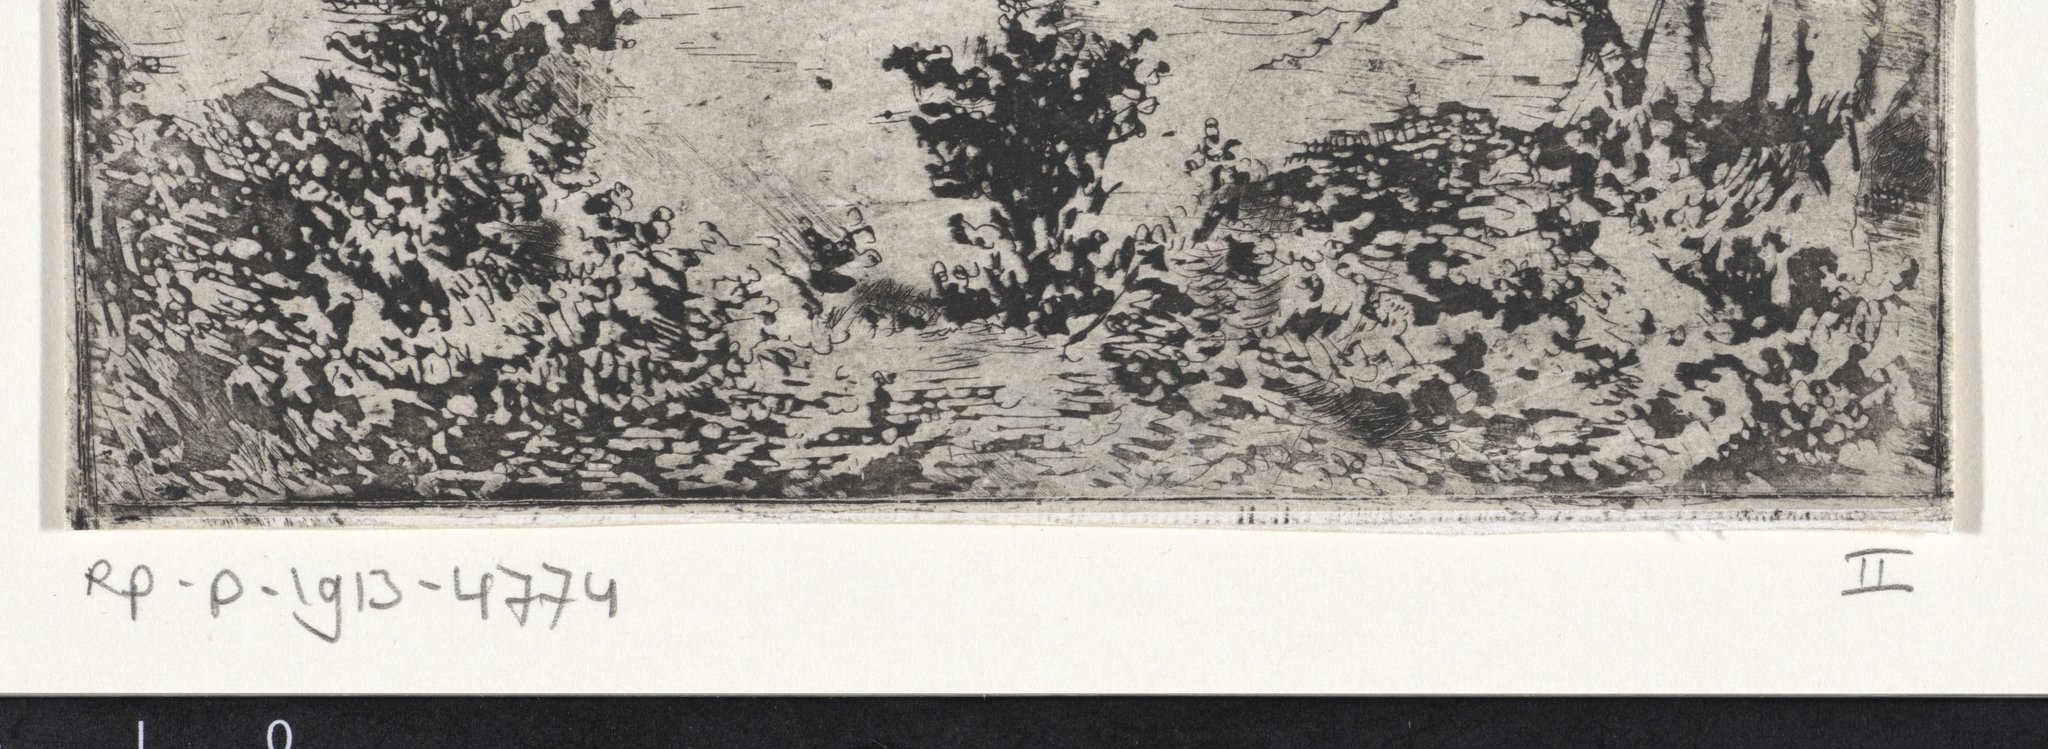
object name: print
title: Landschap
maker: arnoud schaepkens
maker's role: print maker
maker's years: 1816-1904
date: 1831-1904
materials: paper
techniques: drypoint, etching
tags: trees, landscapes in the temperate zone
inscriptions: collector's mark: Lugt 2228